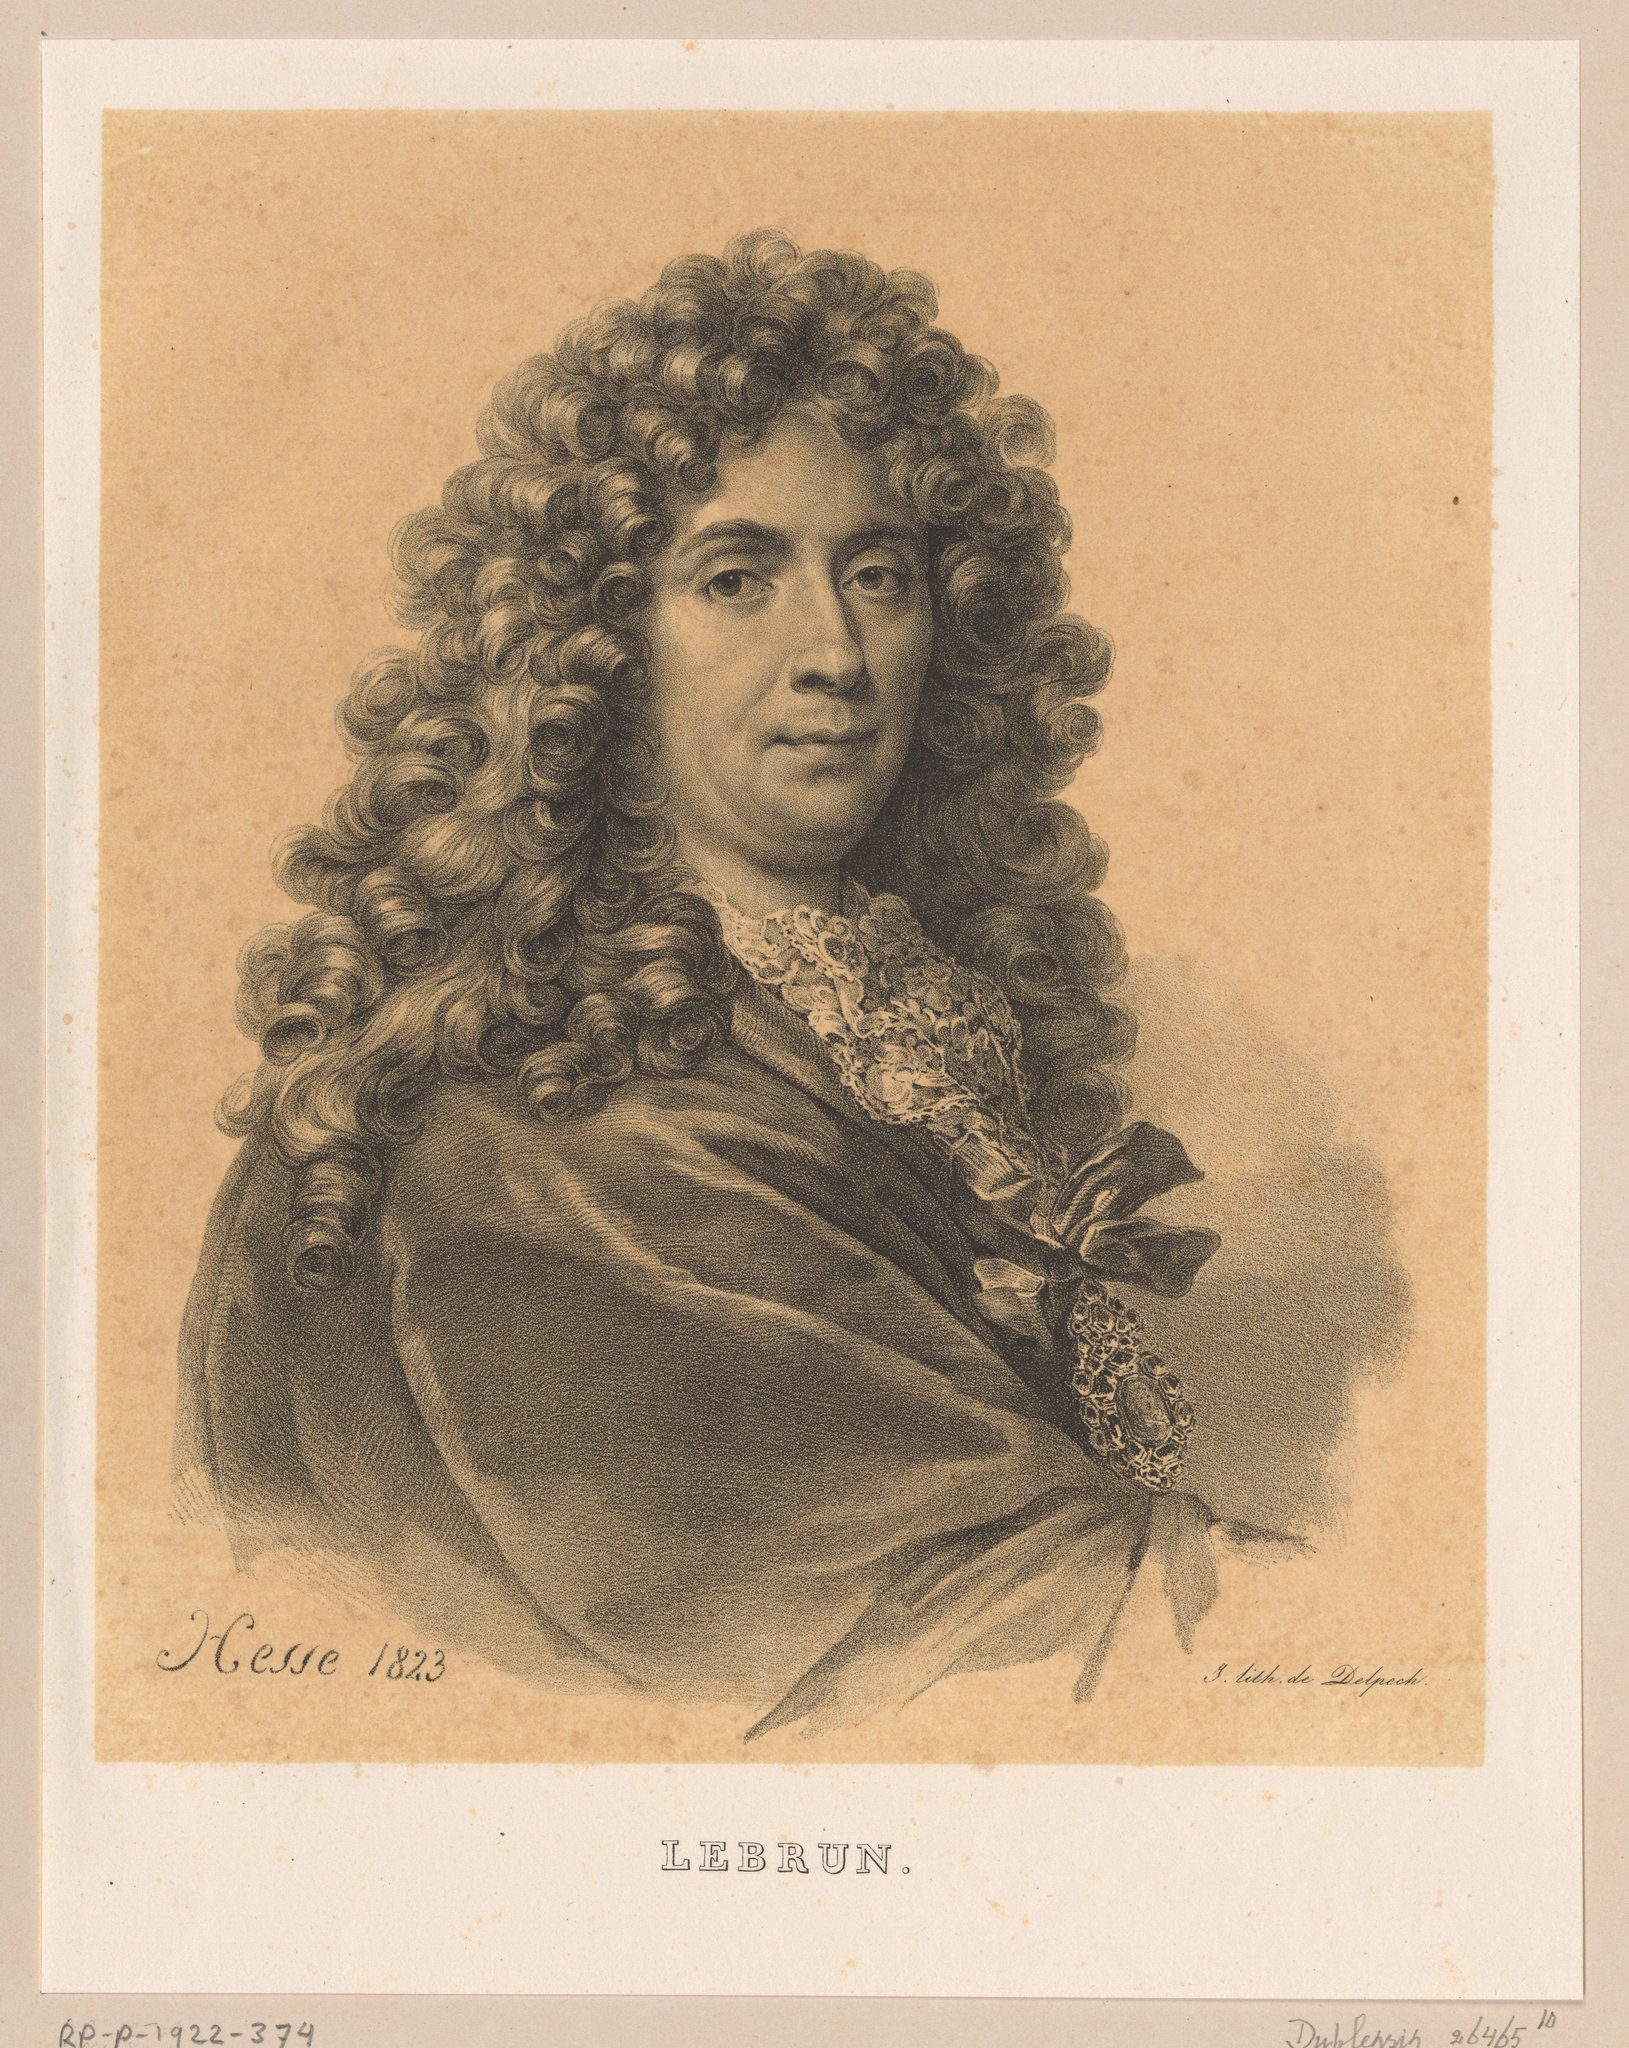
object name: print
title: Portret van Charles Le Brun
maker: françois séraphin delpech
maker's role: print maker, printer, publisher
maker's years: 1778-1825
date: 1823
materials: paper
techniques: tone lithography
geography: paris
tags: paris, print maker, draughtsman, charles le brun, historical persons, portrait, self-portrait of painter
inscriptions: collector's mark: Lugt 2233